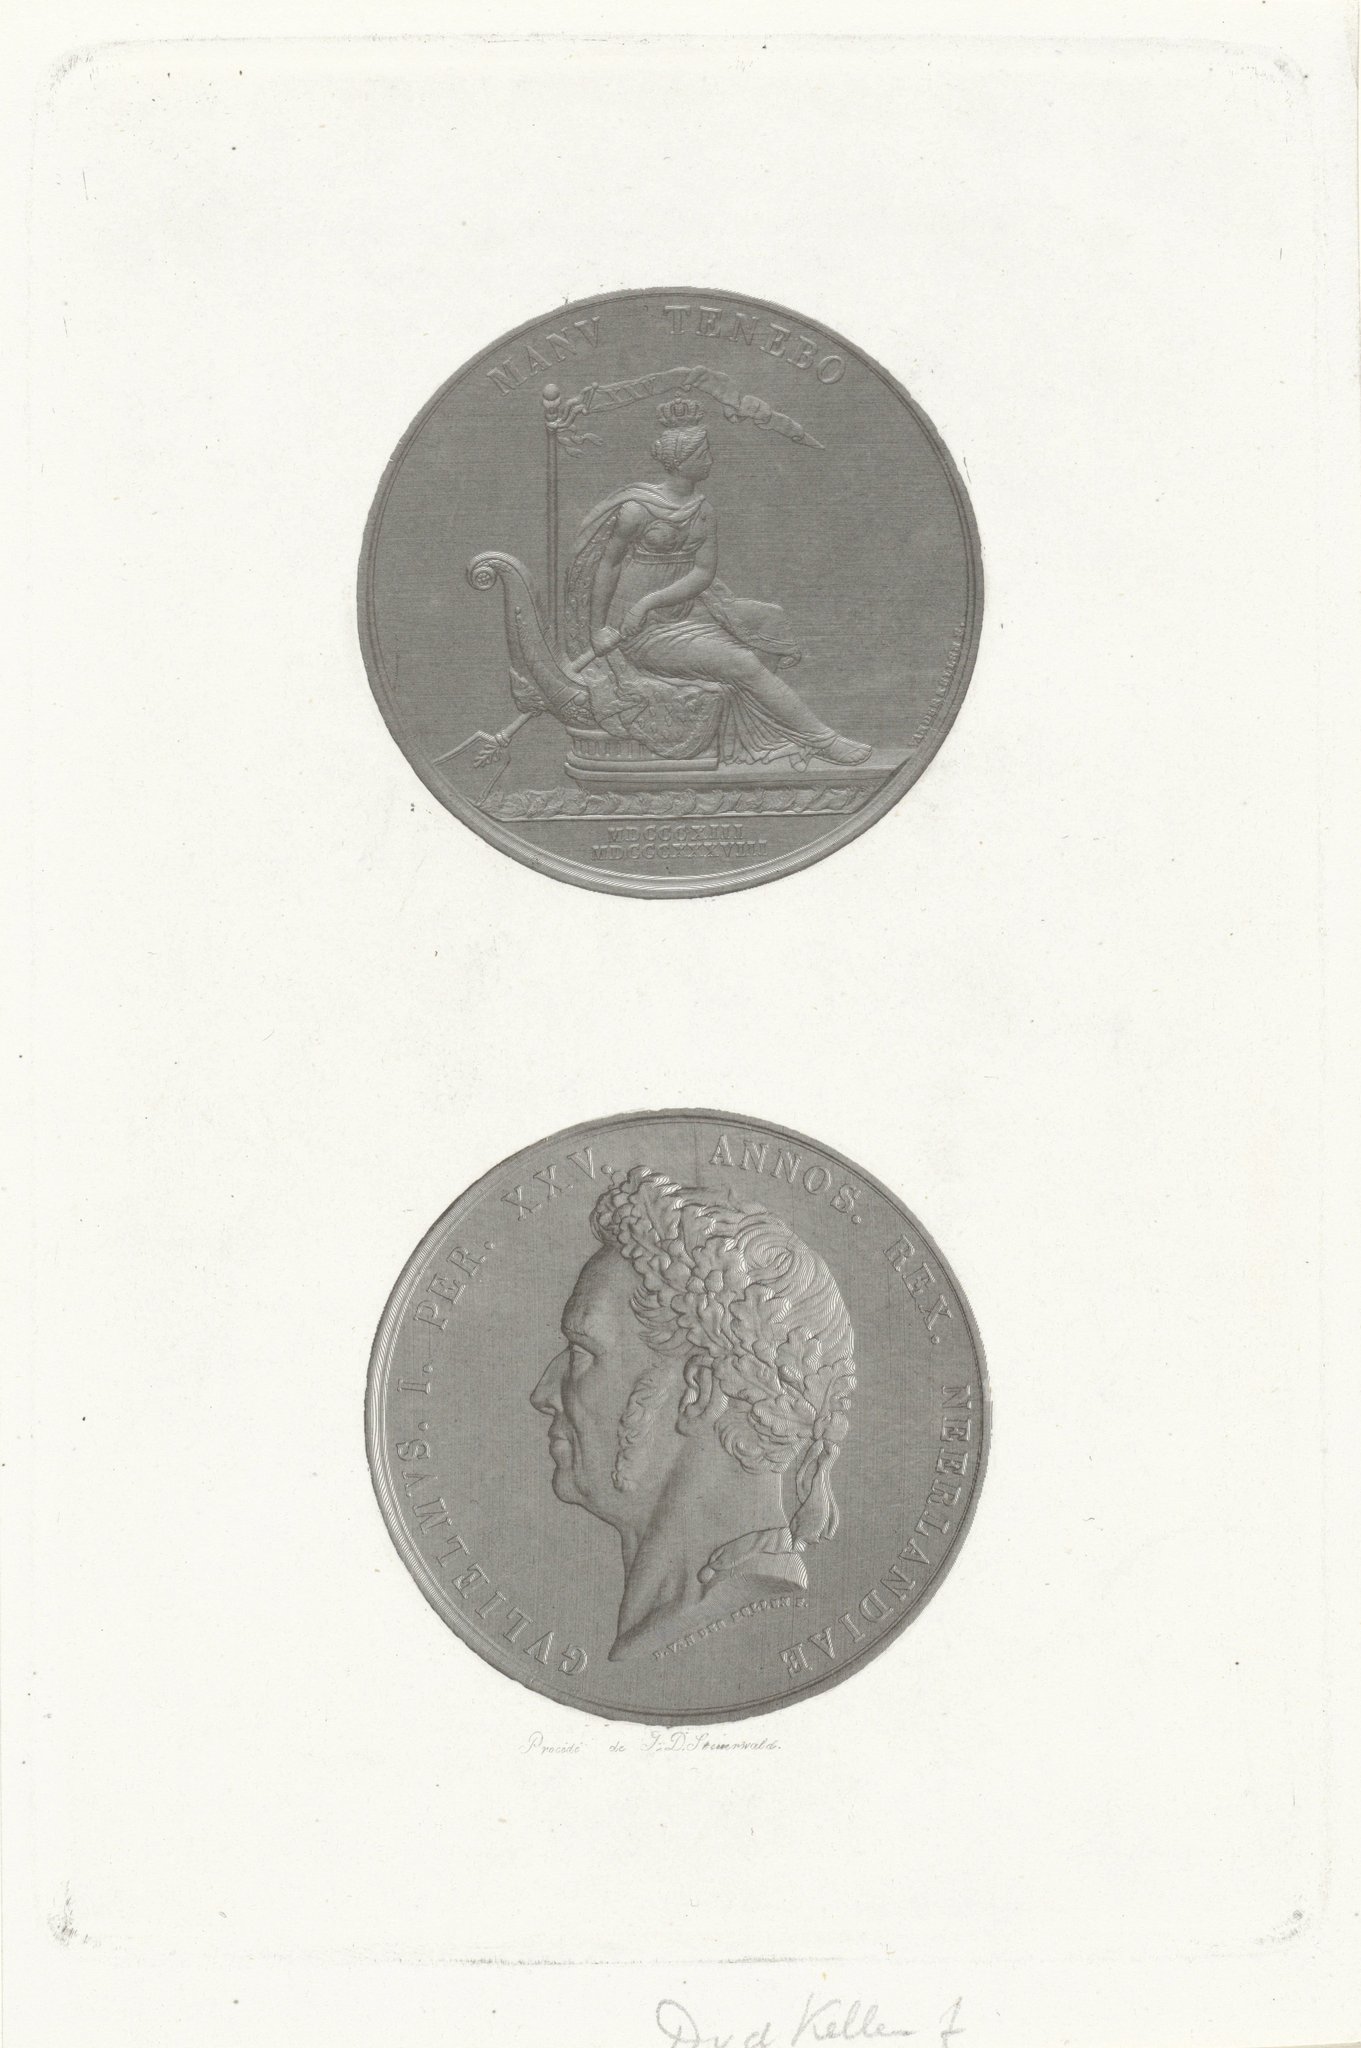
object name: print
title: Munt ter gelegenheid van jubileum koning Willem I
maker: jan dam steuerwald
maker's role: print maker, printer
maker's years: 1805-1869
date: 1838-1840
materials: paper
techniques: relief engraving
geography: netherlands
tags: the hague, william i of the netherlands, coin, king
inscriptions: collector's mark: Lugt 2228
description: De voor- en achterzijde van een munt ter gelegenheid van het 25-jarig koningsschap van Willem I. Boven de gekroonde Hollandse maagd. Onder het portret van Willem I Frederik, koning der Nederlanden.